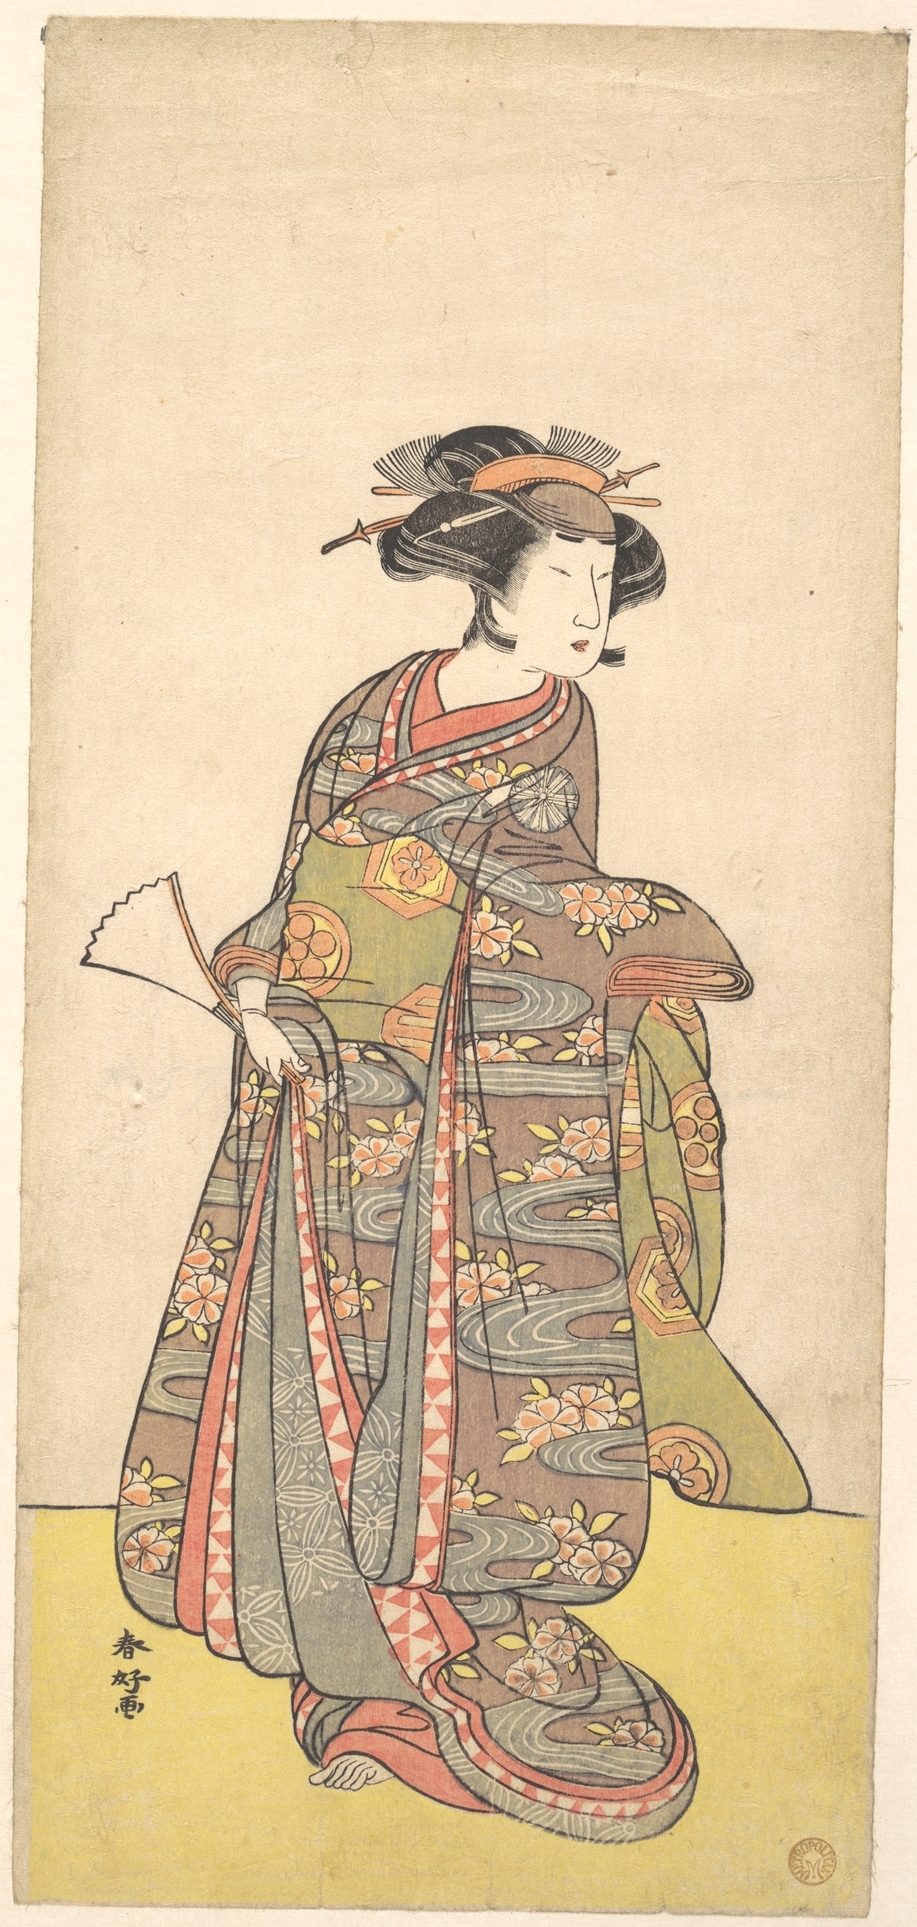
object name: print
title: The First Nakamura Tomijuro as a Woman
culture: japanese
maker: katsukawa shunkō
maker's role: artist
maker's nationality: japanese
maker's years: 1743-1812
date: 1777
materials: ink, paper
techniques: woodblock print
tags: men,women,actors